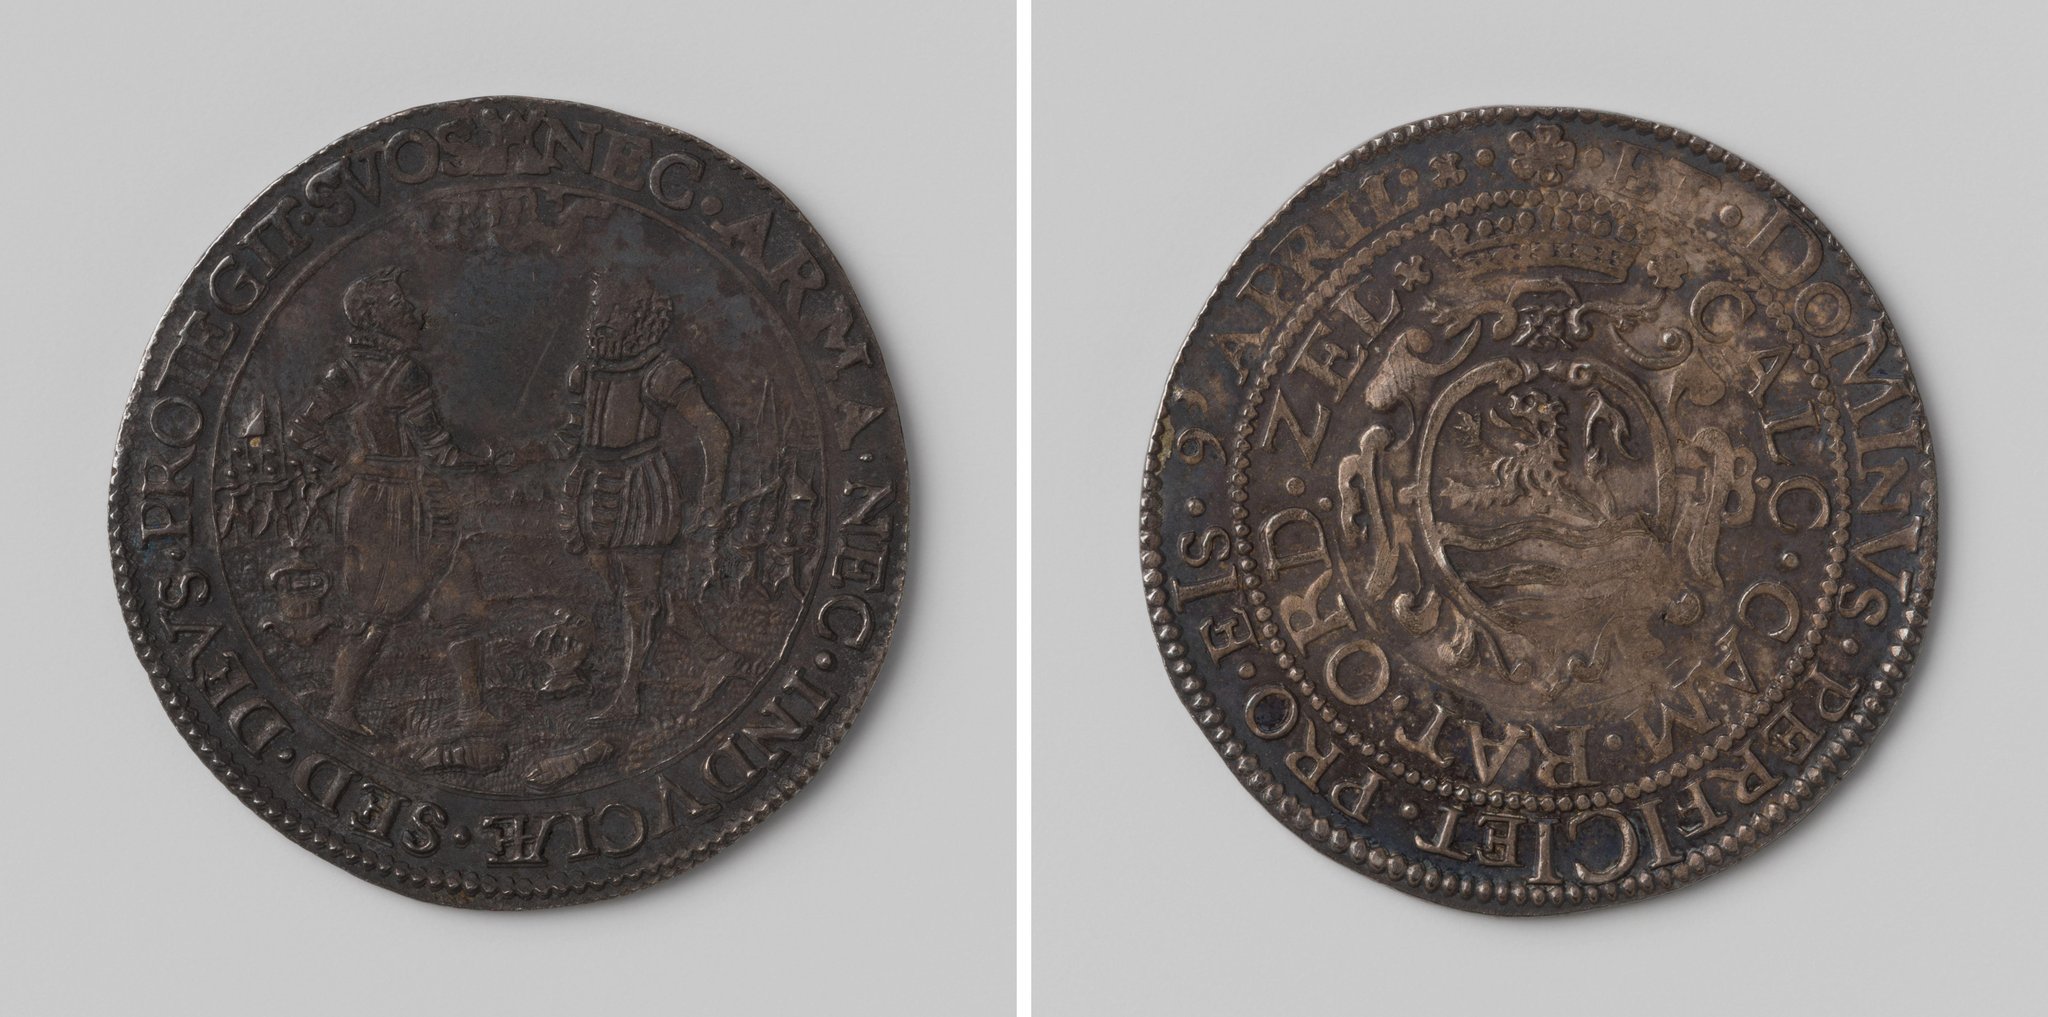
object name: jeton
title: Sluiting van het Twaalfjarig Bestand tussen de Republiek en Spanje, rekenpenning geslagen op last van de rekenkamer van Zeeland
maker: Anonymous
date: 1609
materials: silver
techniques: striking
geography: middelburg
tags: the hague, maurice (prince of orange), zeeland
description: Zilveren penning. Voorzijde: beschenen door hemellicht met daarin naam Jehova in Hebreeuws schrift, schudden twee mannen, voorstellende Maurits en Spinola, die hun helmen hebben afgezet, elkaar hand; op achtergrond de beide legers binnen omschrift. Keerzijde: gekroond wapenschild op cartouche binnen tweeregelig omschift